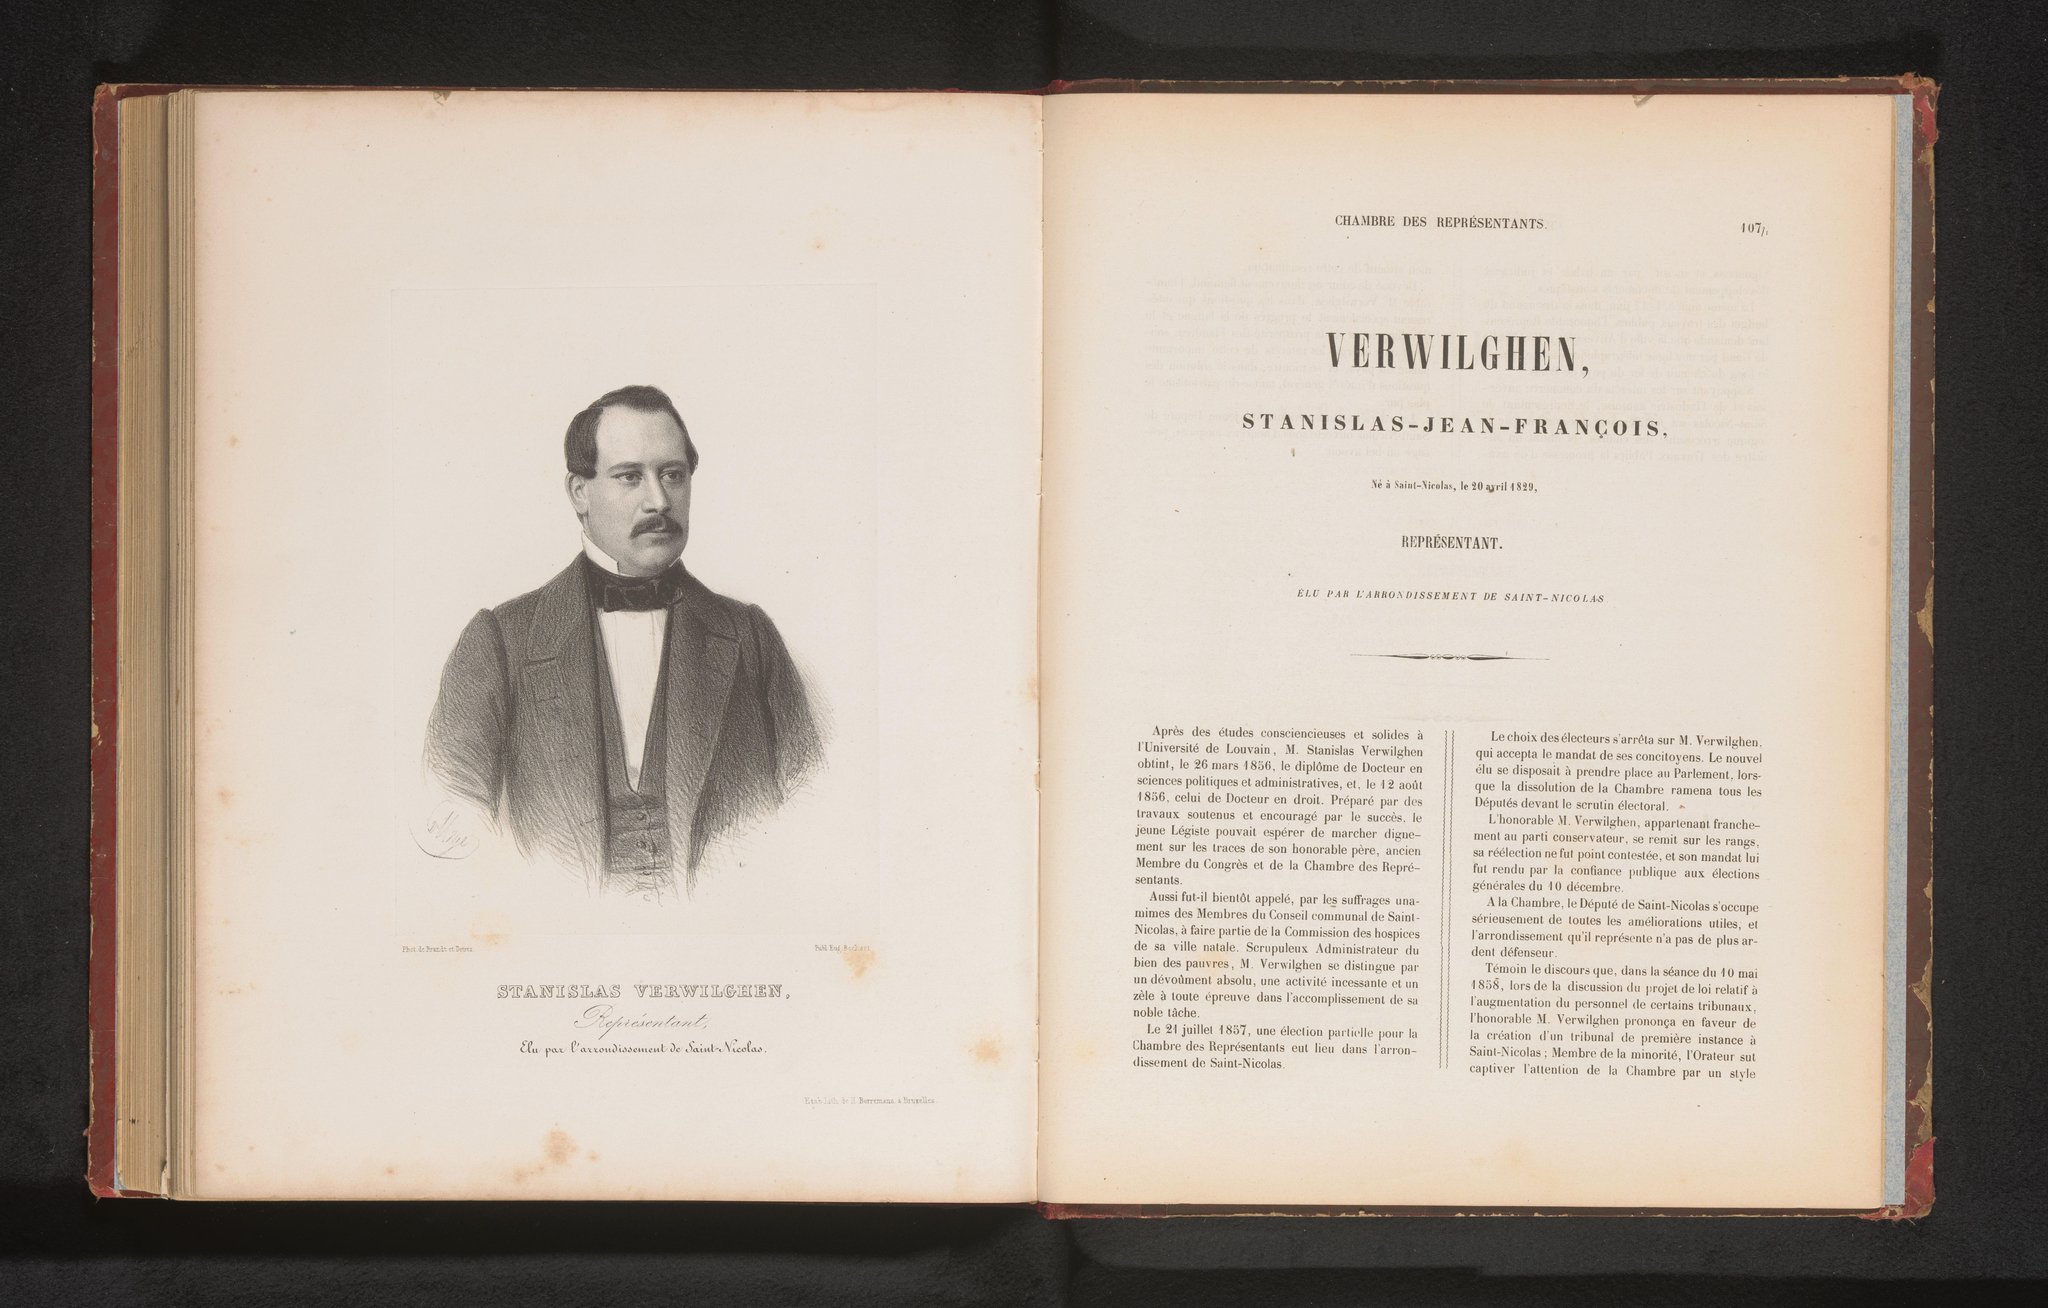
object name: page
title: Reproductie van een foto van een portret van Stanislas Verwilghen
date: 1853-1858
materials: paper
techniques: lithograph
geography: brussels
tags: politician, stanislas jean françois verwilghen, historical persons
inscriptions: inscription: ‘Représentant,/ Elu par l'arrondissement de Saint Nicolas.’